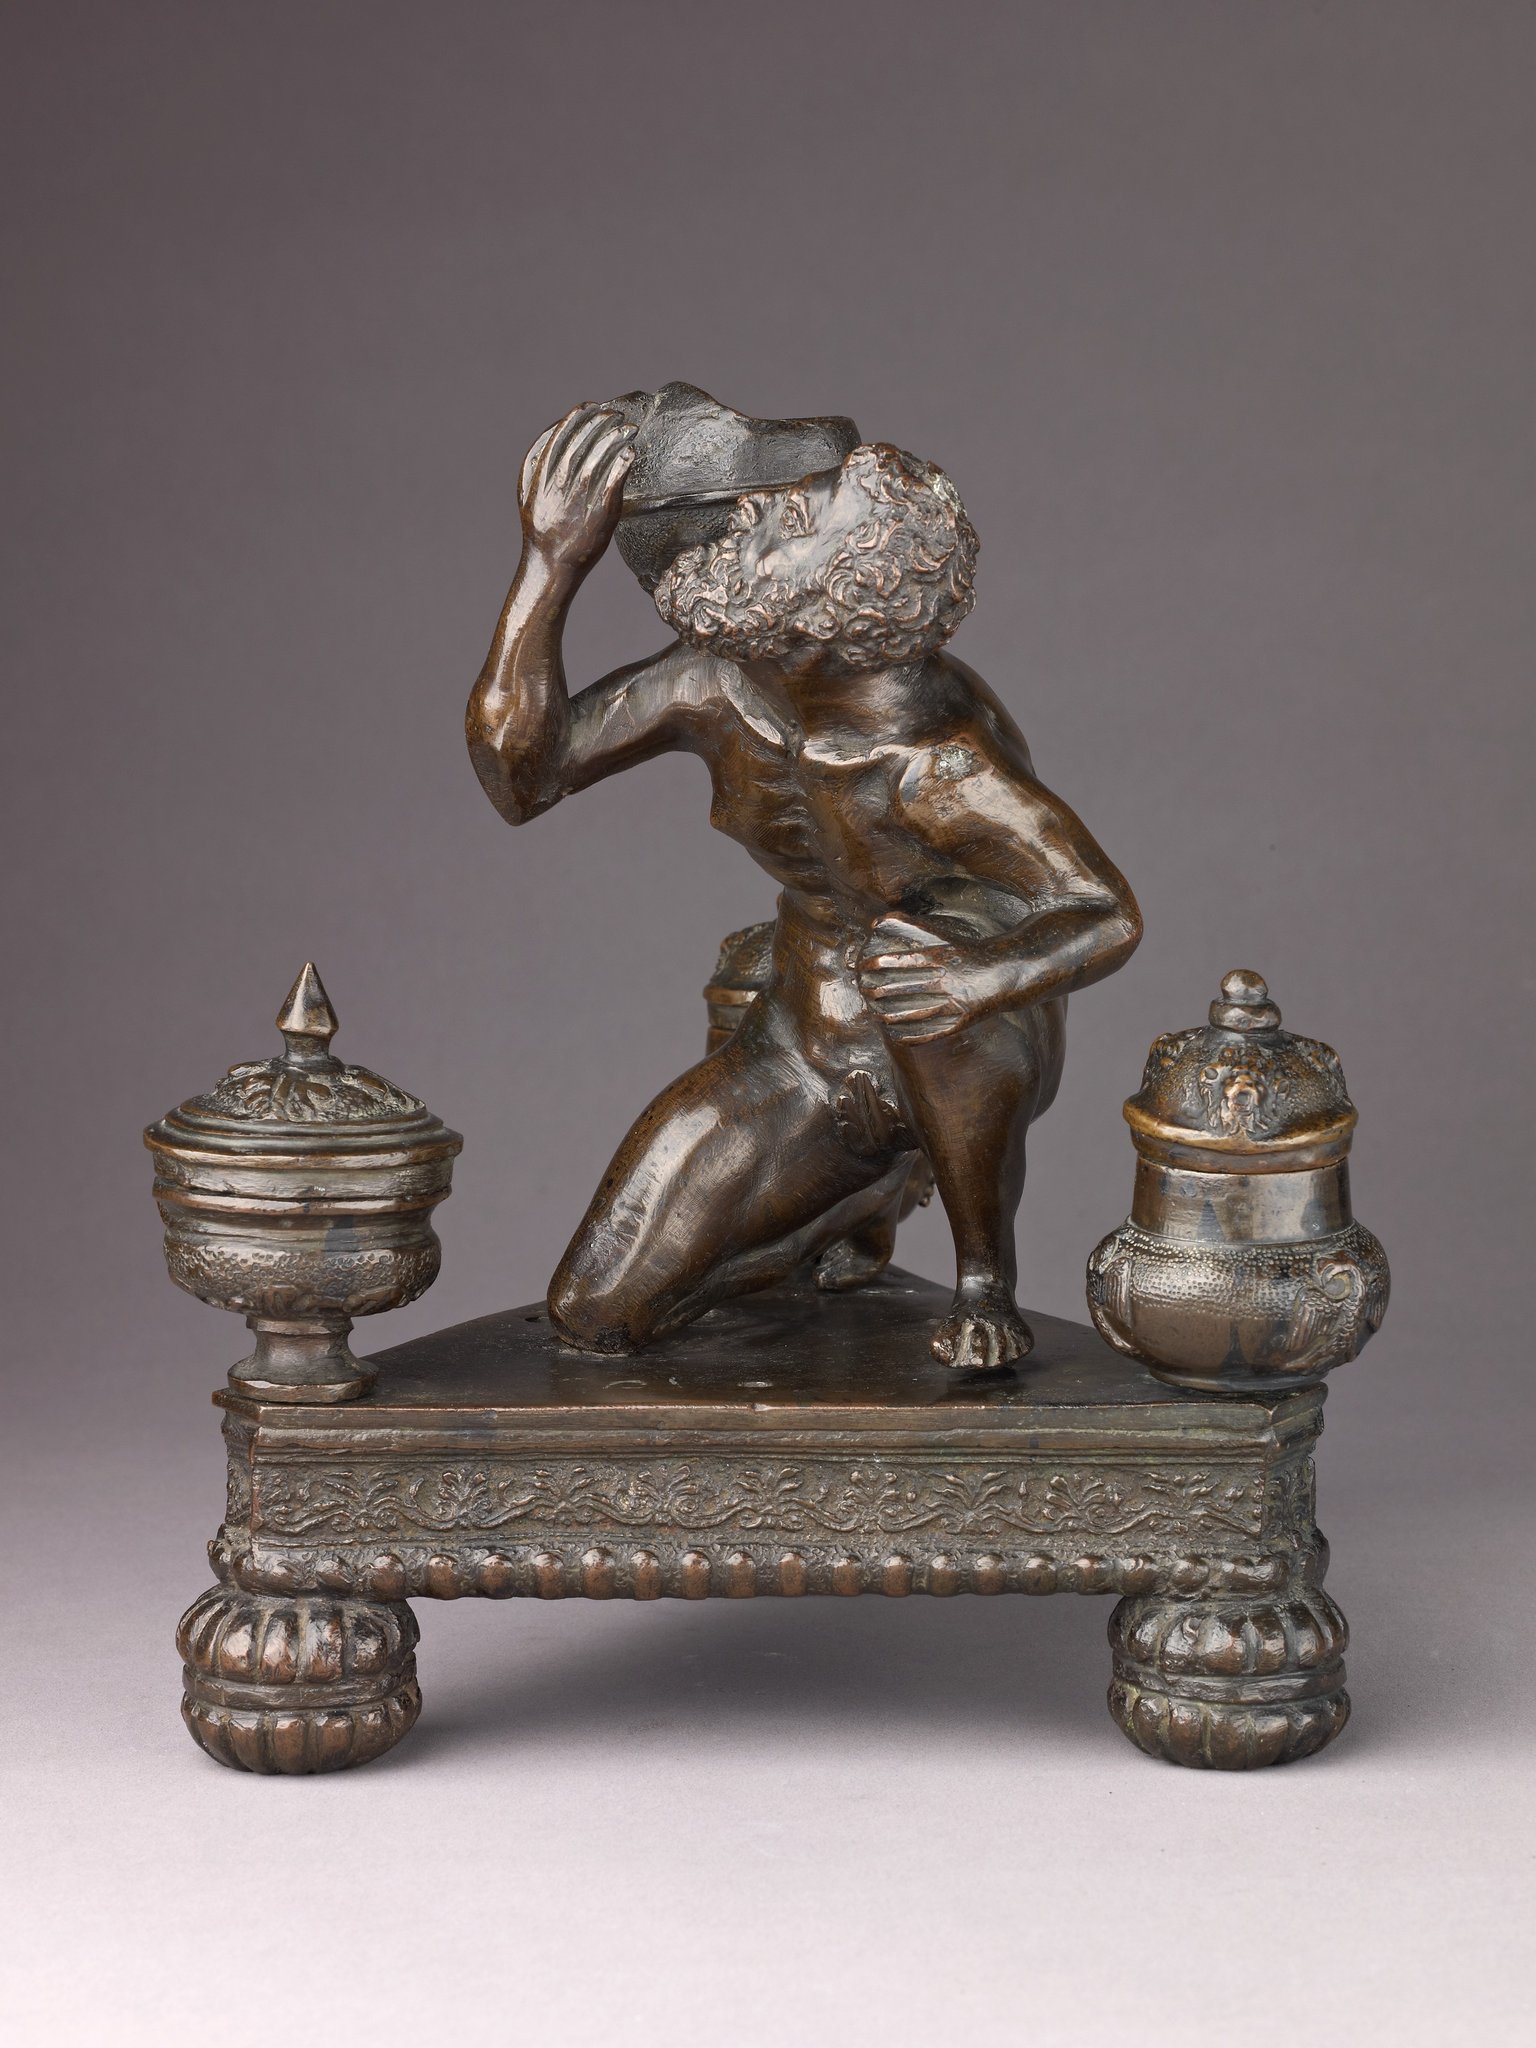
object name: inkwell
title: Inkwell in the Form of Atlas Holding a Globe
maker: severo calzetta da ravenna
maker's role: artist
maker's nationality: italian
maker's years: 1496-1543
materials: copper alloy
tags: men,globes